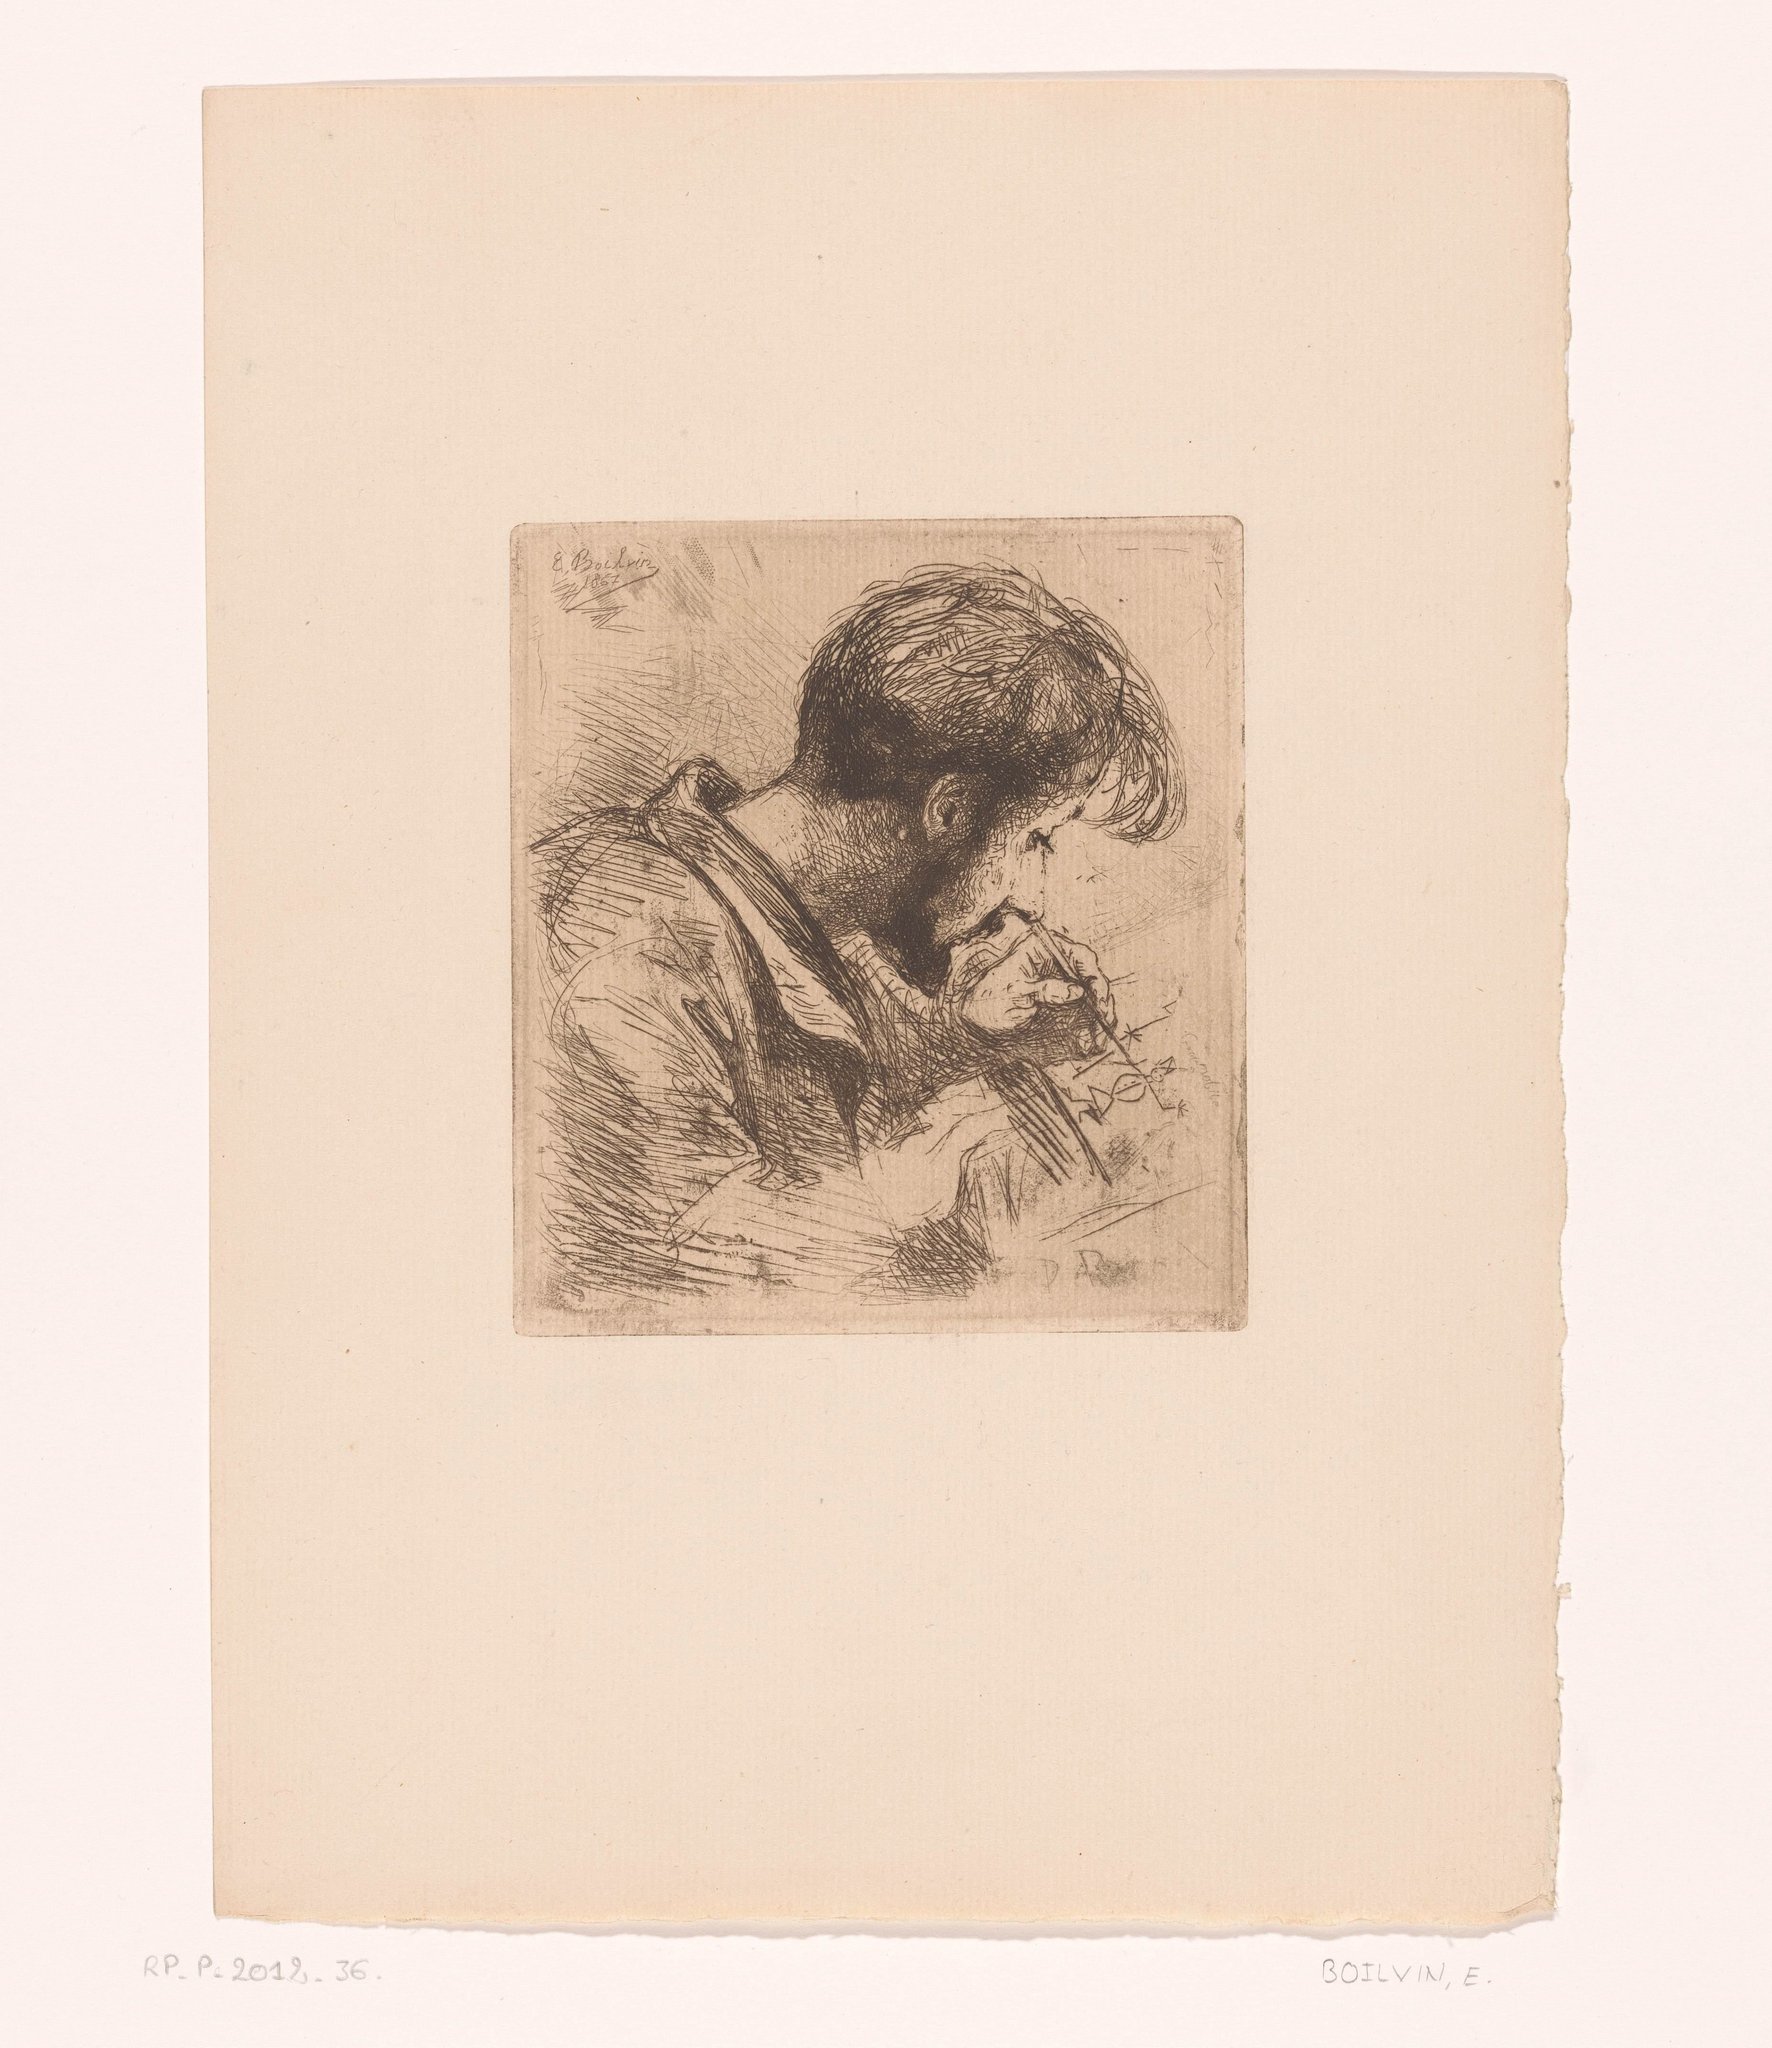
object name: print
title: Portret van Paul Adolphe Rajon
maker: emile boilvin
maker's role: print maker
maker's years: 1845-1899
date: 1867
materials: paper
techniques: etching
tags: print maker, paul adolphe rajon, portrait, self-portrait of artist, print, e.g.: engraving, etching, lithograph (+ artist at work)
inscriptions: annotation: ‘Donnè par M. Amanien le 10 Décembre 1879 (?)’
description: Een portret van kunstenaar Paul Adolphe Rajon die met een etsnaald op een koperplaat werkt. Op de koperplaat bevindt zich een voorstelling van een soldaat met daarboven het opschrift 'Garde Mobile'.